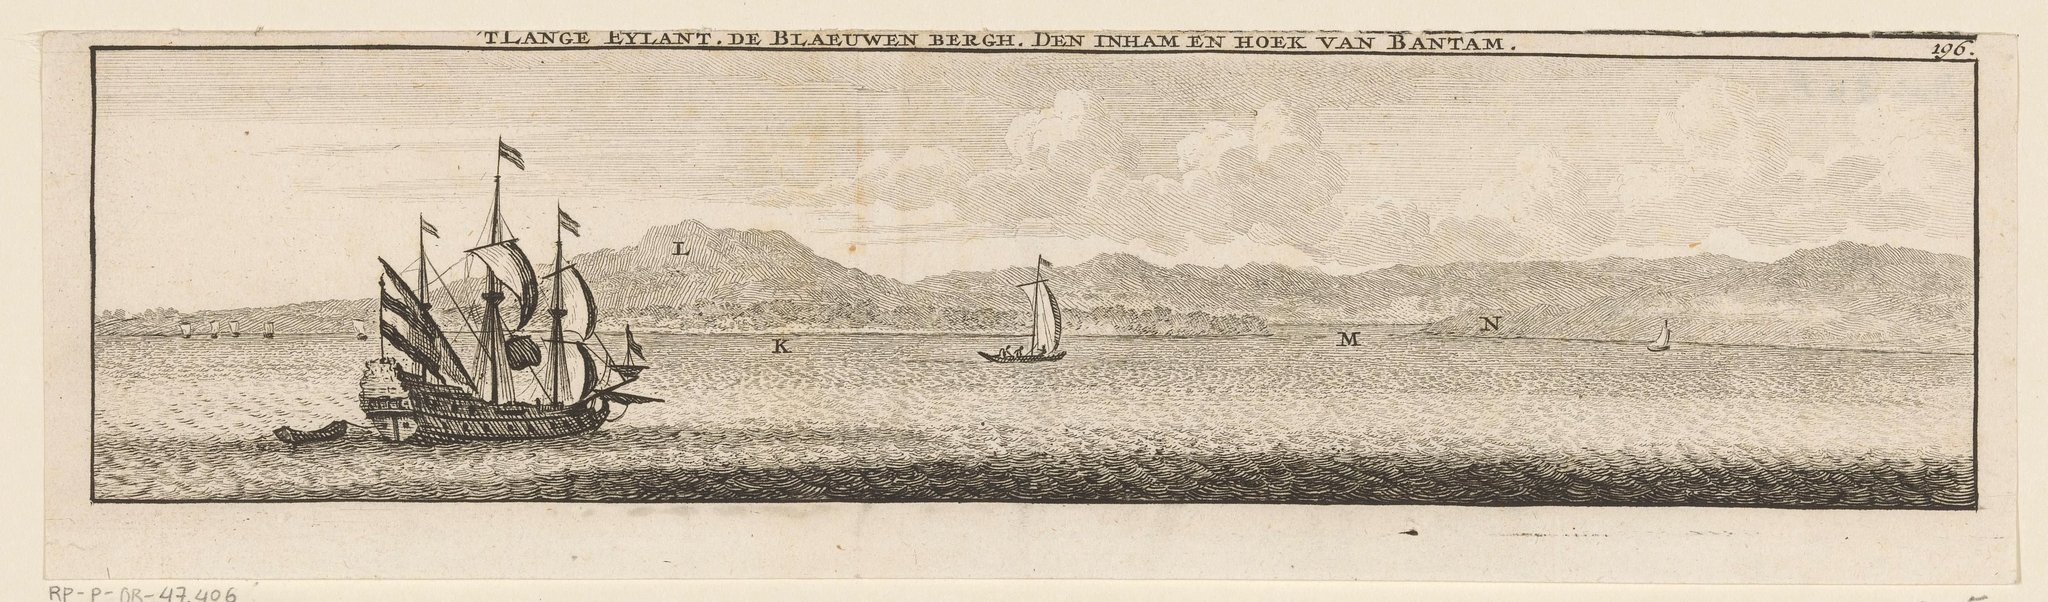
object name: print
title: Gezicht op de Baai van Bantam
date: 1714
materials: paper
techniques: engraving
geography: amsterdam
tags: gulf, bay, island, sailing-ship, sailing-boat, landscapes with waters, waterscapes, seascapes (in the temperate zone), java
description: Fragment van een prent afkomstig uit: Bruin, Cornelis de. Reizen over Moskovie door Persie en Indie. Amsterdam: Rudolph & Gerard Wetstein, Johannes van Oosterwyk, Hendrik van de Gaete, 1714.